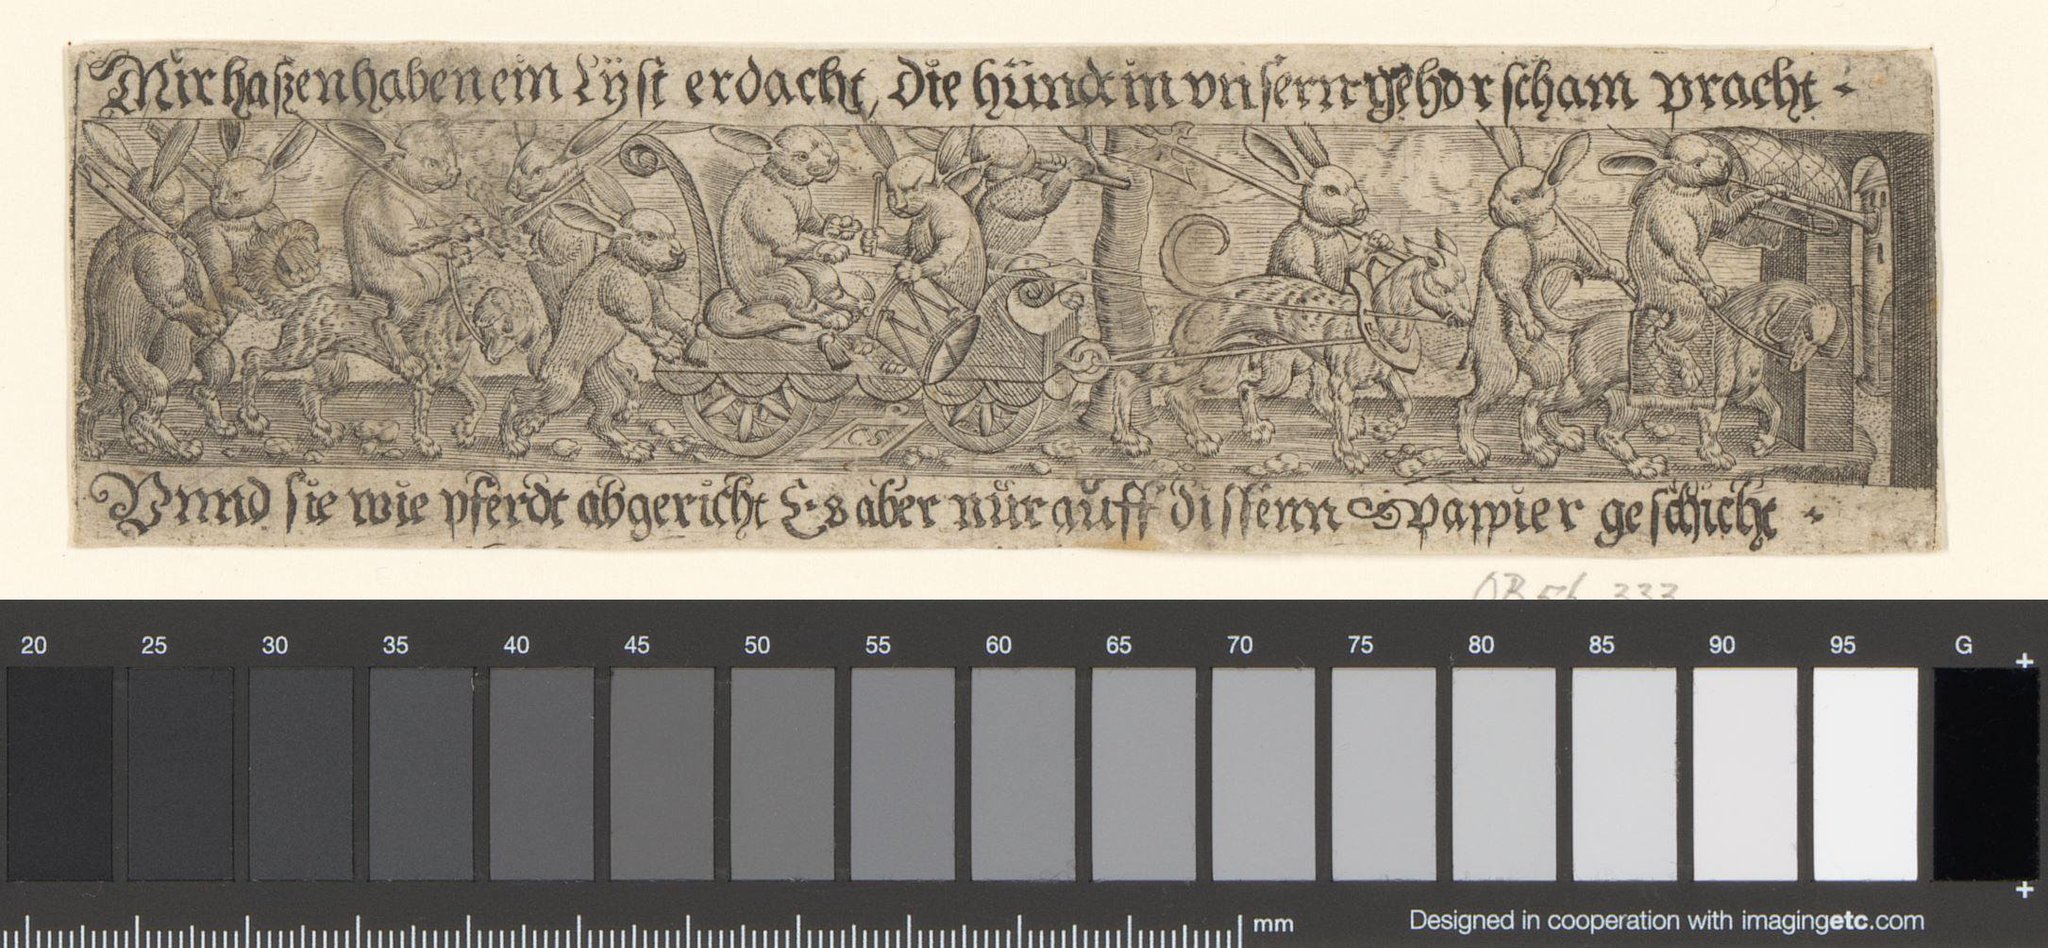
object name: print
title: Konijnen triomferen over wolven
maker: conrad saldörffer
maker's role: print maker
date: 1563-1583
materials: paper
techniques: etching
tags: game, hunted animals, conqueror triumphing, triumphal entry of victor, rodents: rabbit, beasts of prey, predatory animals: wolf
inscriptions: collector's mark: Lugt 2228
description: Onderdeel van een serie satirische prenten met dieren, waarvan de complete hoeveelheid onbekend is.